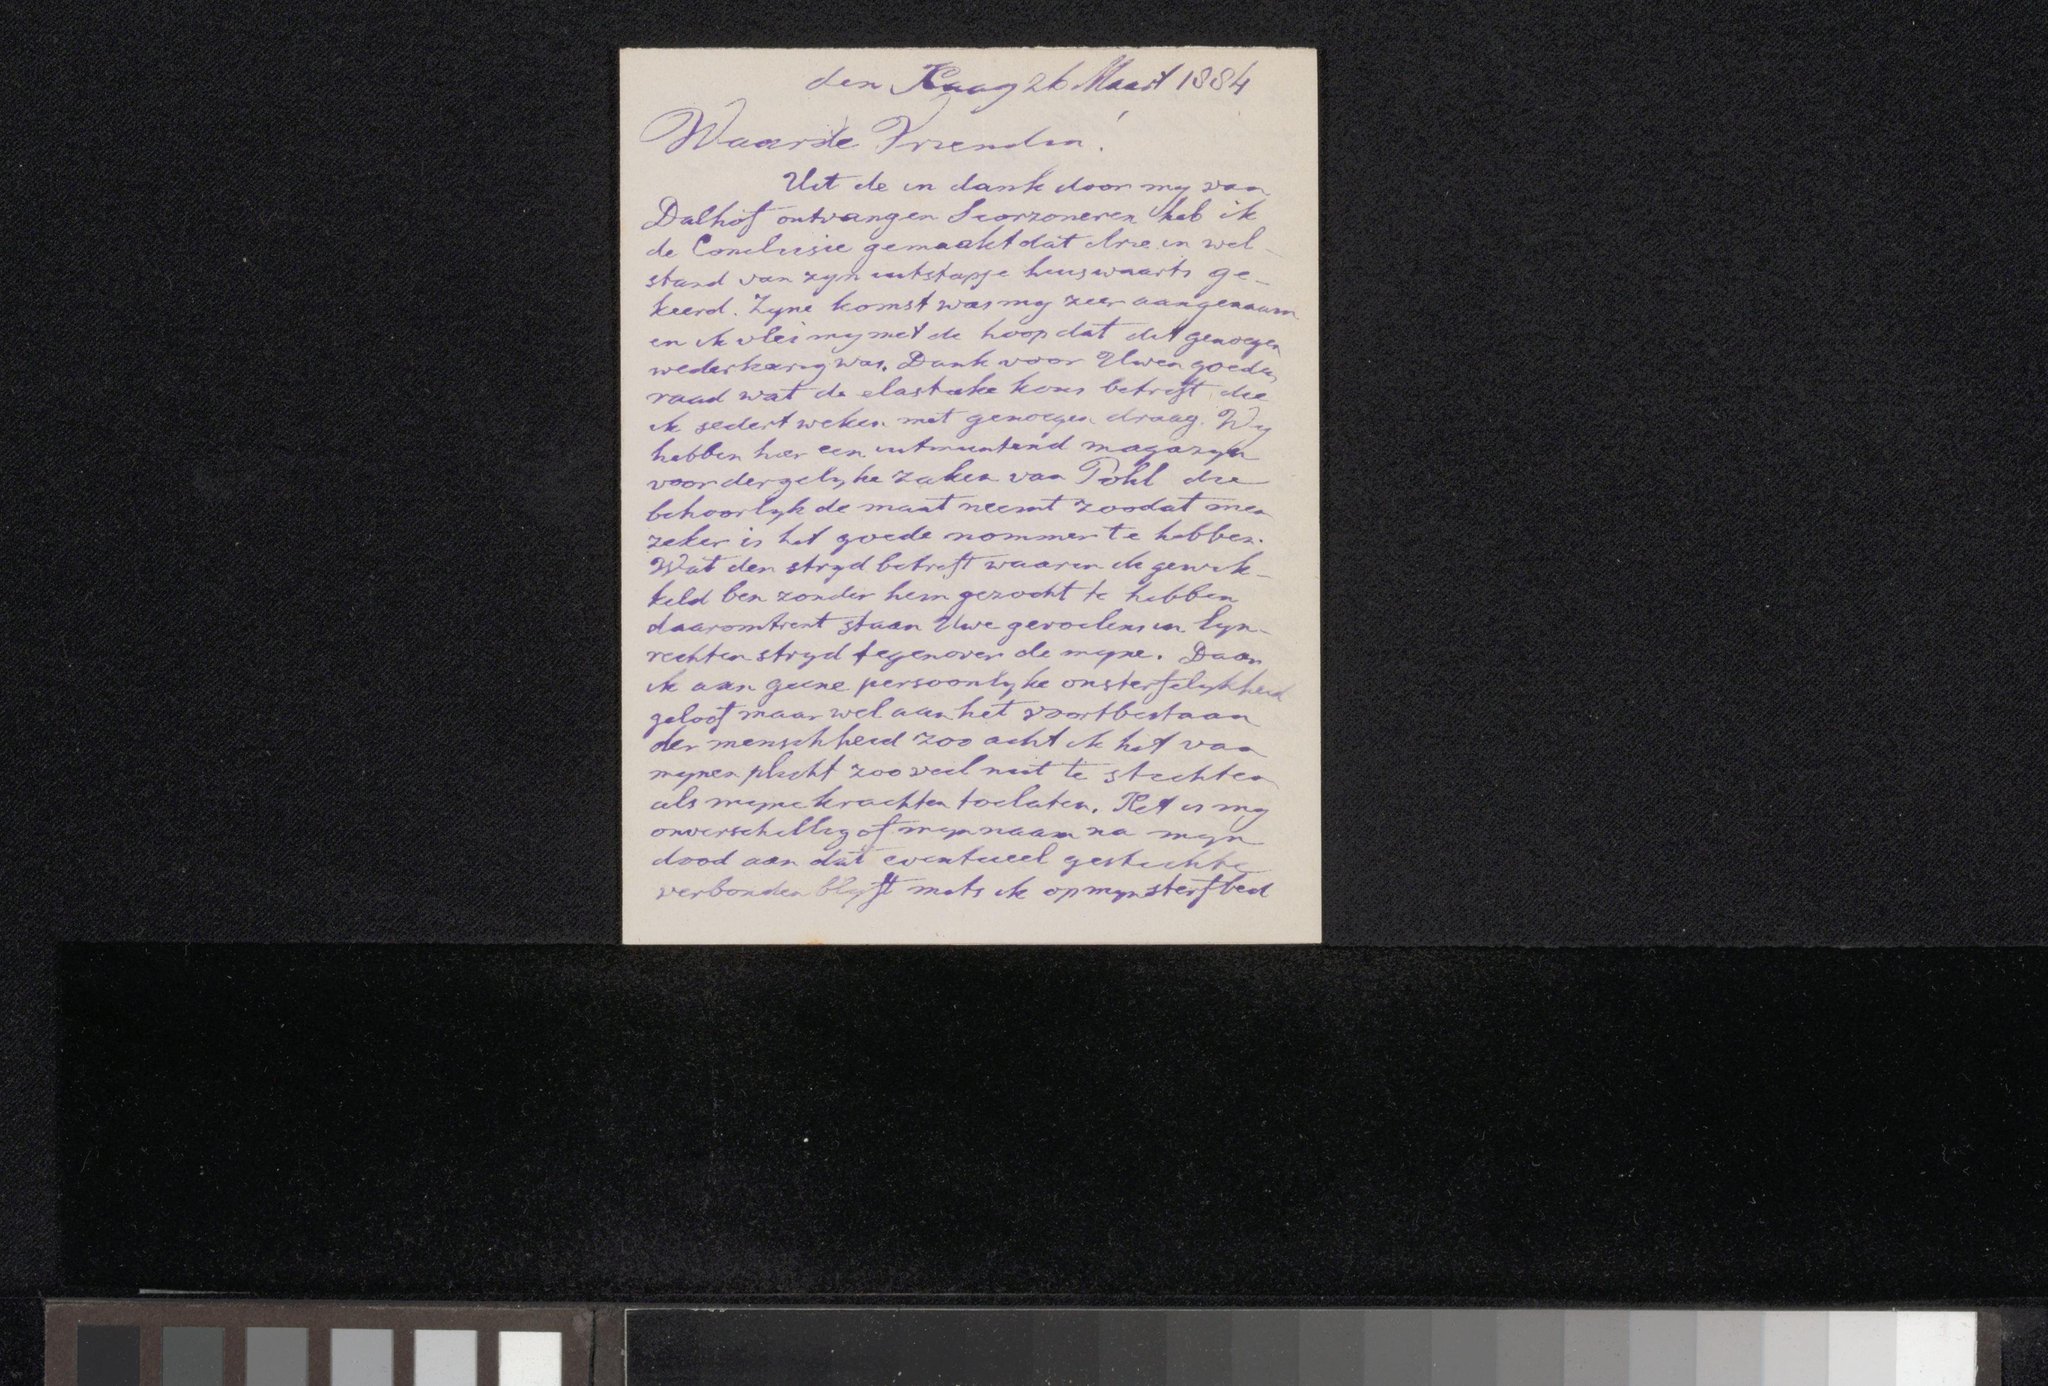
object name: letter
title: Brief aan anoniem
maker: johan eliza de vrij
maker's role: scheikundige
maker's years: 1813-1898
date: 1884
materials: ink, paper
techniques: pen, writing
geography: the hague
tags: dordrecht, print maker, ary johannes lamme, art trade, art shop, the graphic arts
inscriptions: collector's mark: Lugt 2228